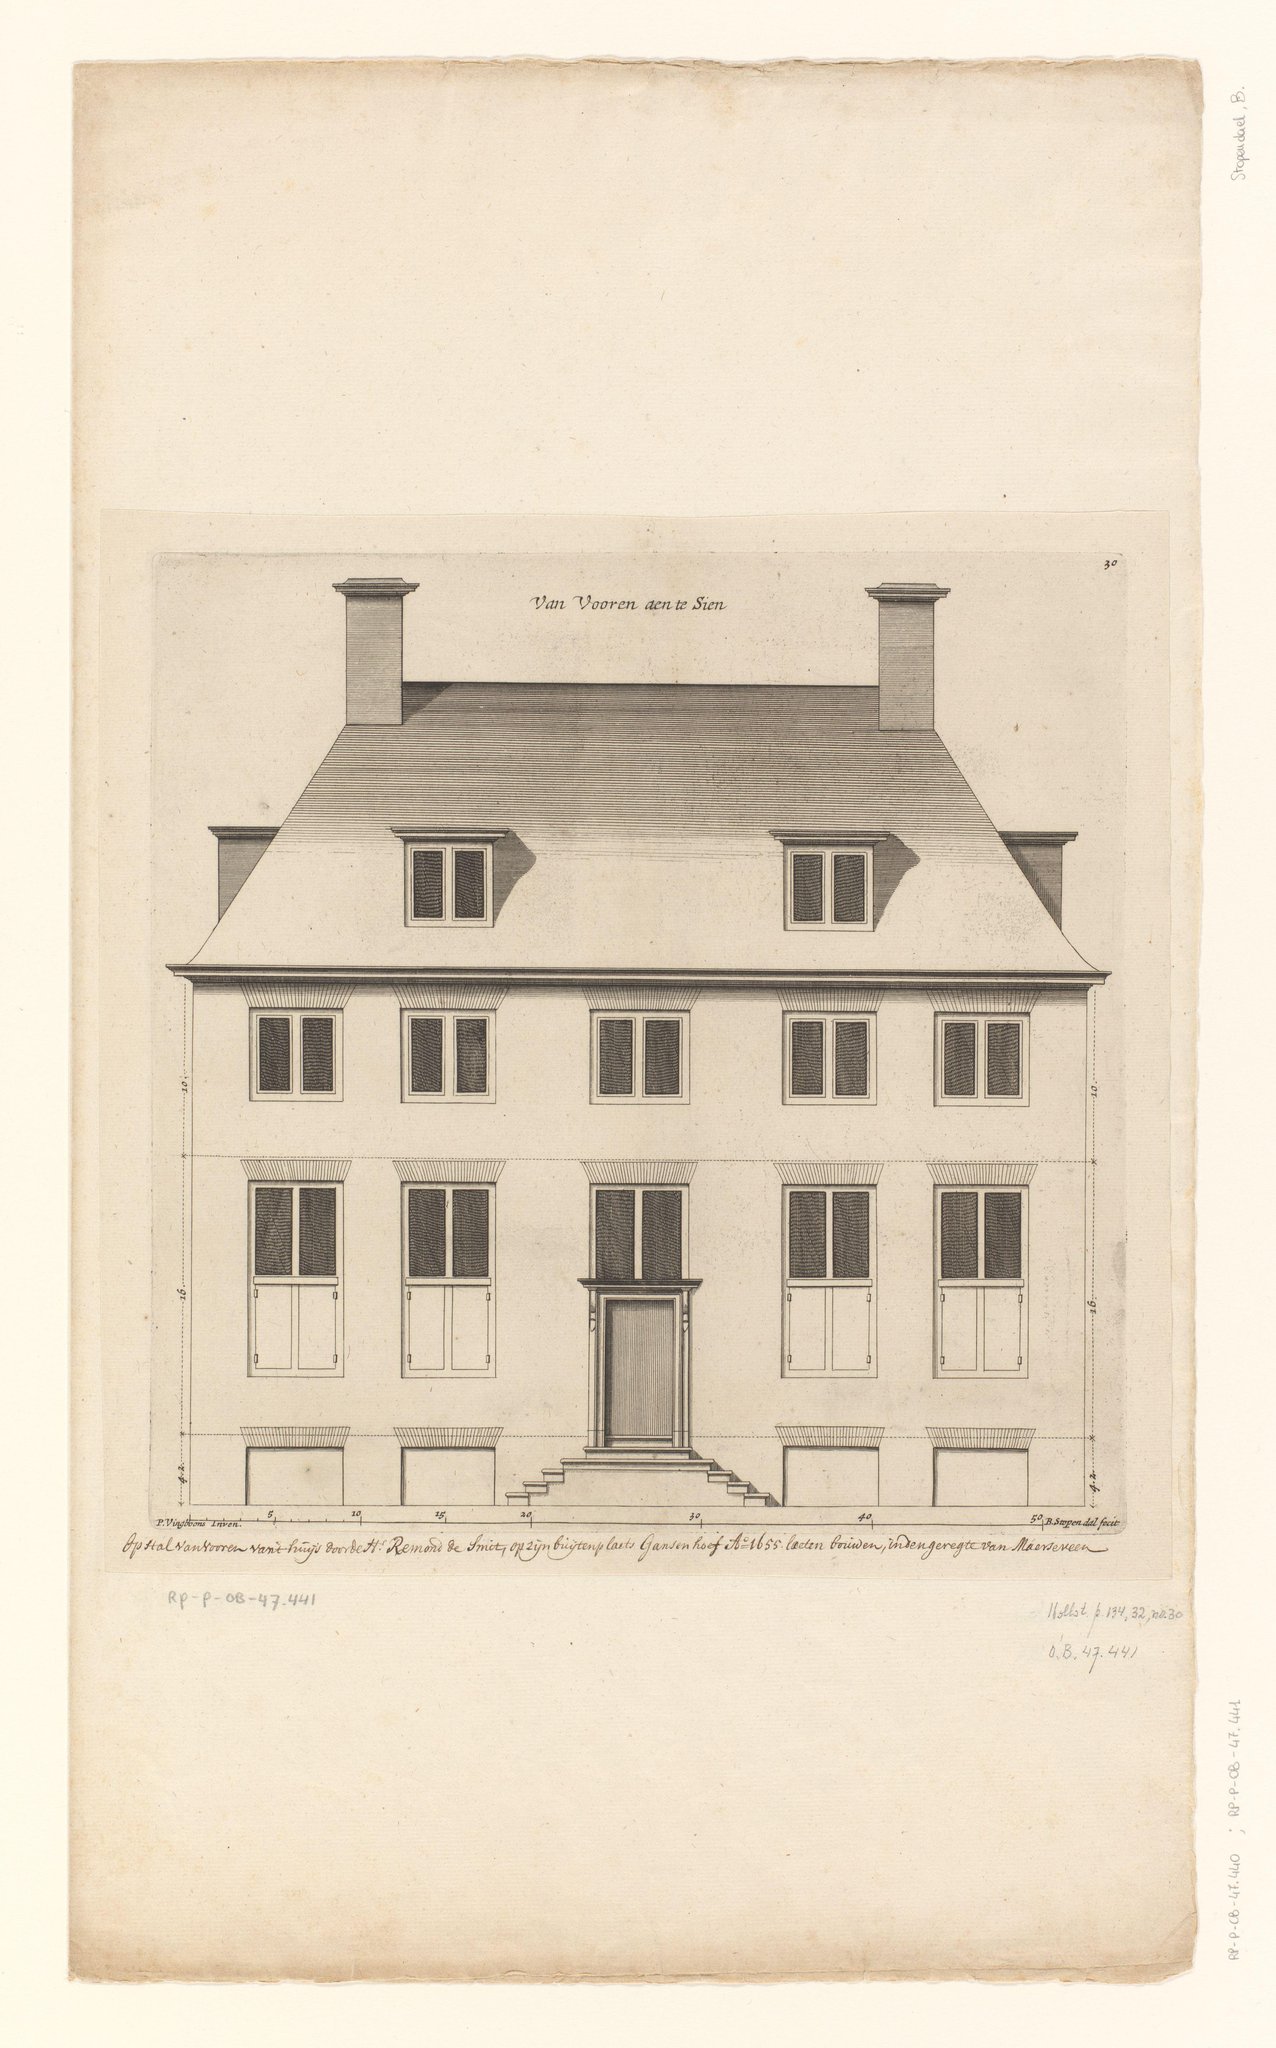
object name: print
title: Achteraanzicht van het huis Gansenhoef te Maarssen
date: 1715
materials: paper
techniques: etching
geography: amsterdam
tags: country-house, maarssen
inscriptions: inscription: ‘Op stal van vooren van 't huijs van agteren door de Hr. Remond de Smit, op zijn buijtenplaets Gansenhoef Ao. 1655. laeten bouwen, in den geregte van Maerseveen’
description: Prent waarschijnlijk uit: De gronden, afbeeldingen en beschryvingen der aldervoornaamste en aldernieuwste gebouwen uyt alle die door Philippus Vingboons (...). Leiden: Pieter van der Aa, 1715. De prent is waarschijnlijk in een eerdere staat gebruikt in publicaties uit 1674, 1687 en 1699. Deze prent is geplakt op een albumblad, dat vast zit aan een ander albumblad. Op het tweede albumblad is deze prent (RP-P-OB-47.440) geplakt.